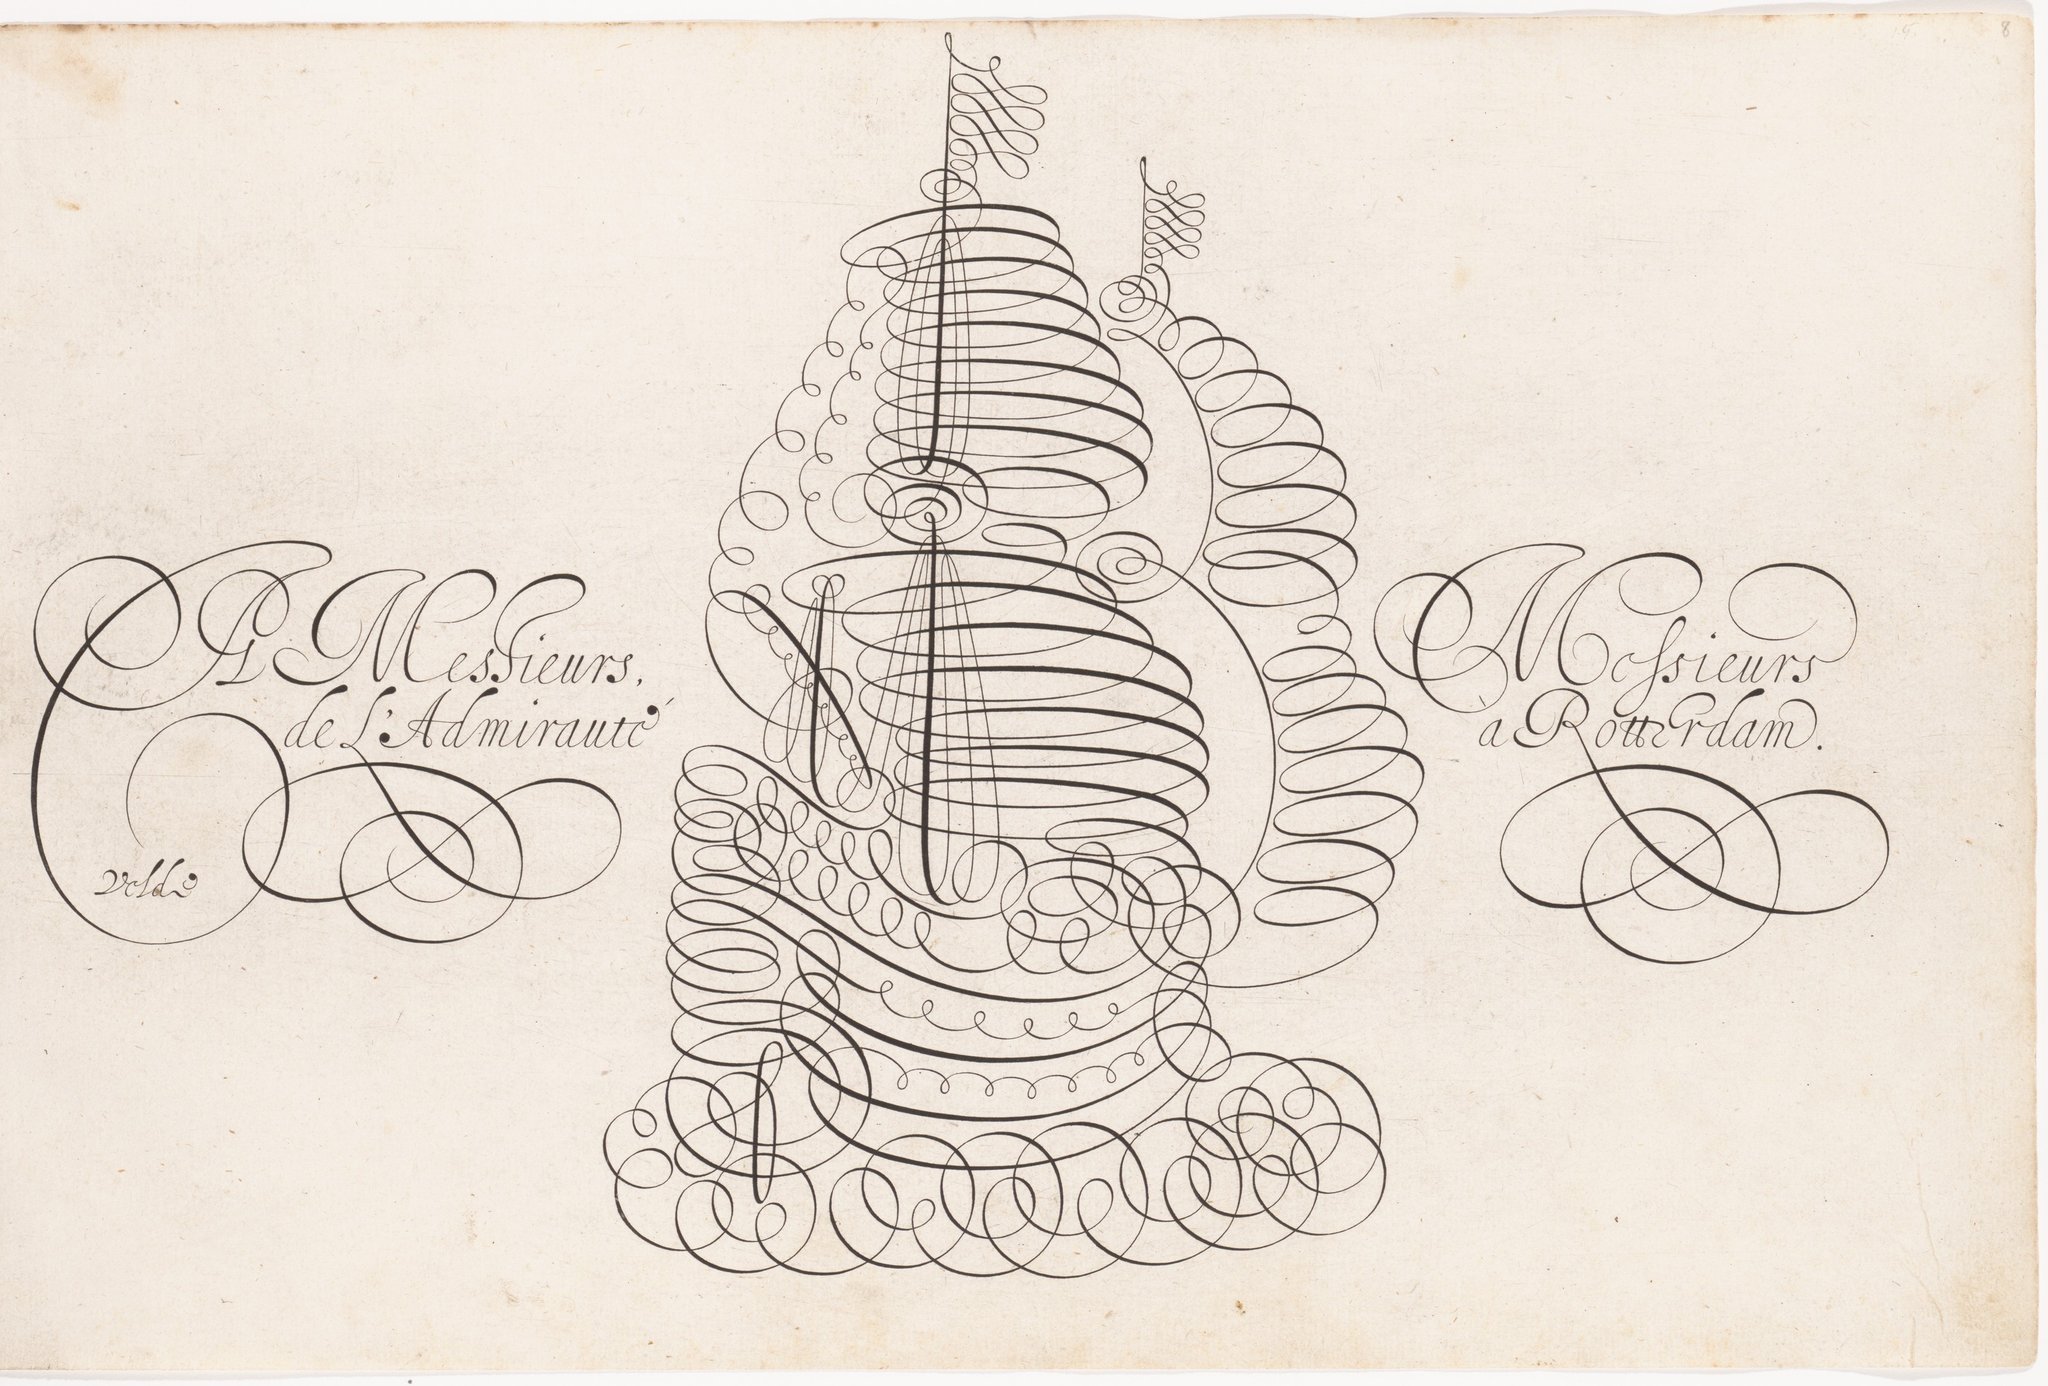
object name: book print ornament architecture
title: Spieghel der Schryfkonste...(Mirror of the Art of Writing)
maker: jan van de velde i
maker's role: author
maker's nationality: netherlandish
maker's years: 1568-1623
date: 1605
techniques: etching, woodcut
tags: calligraphy